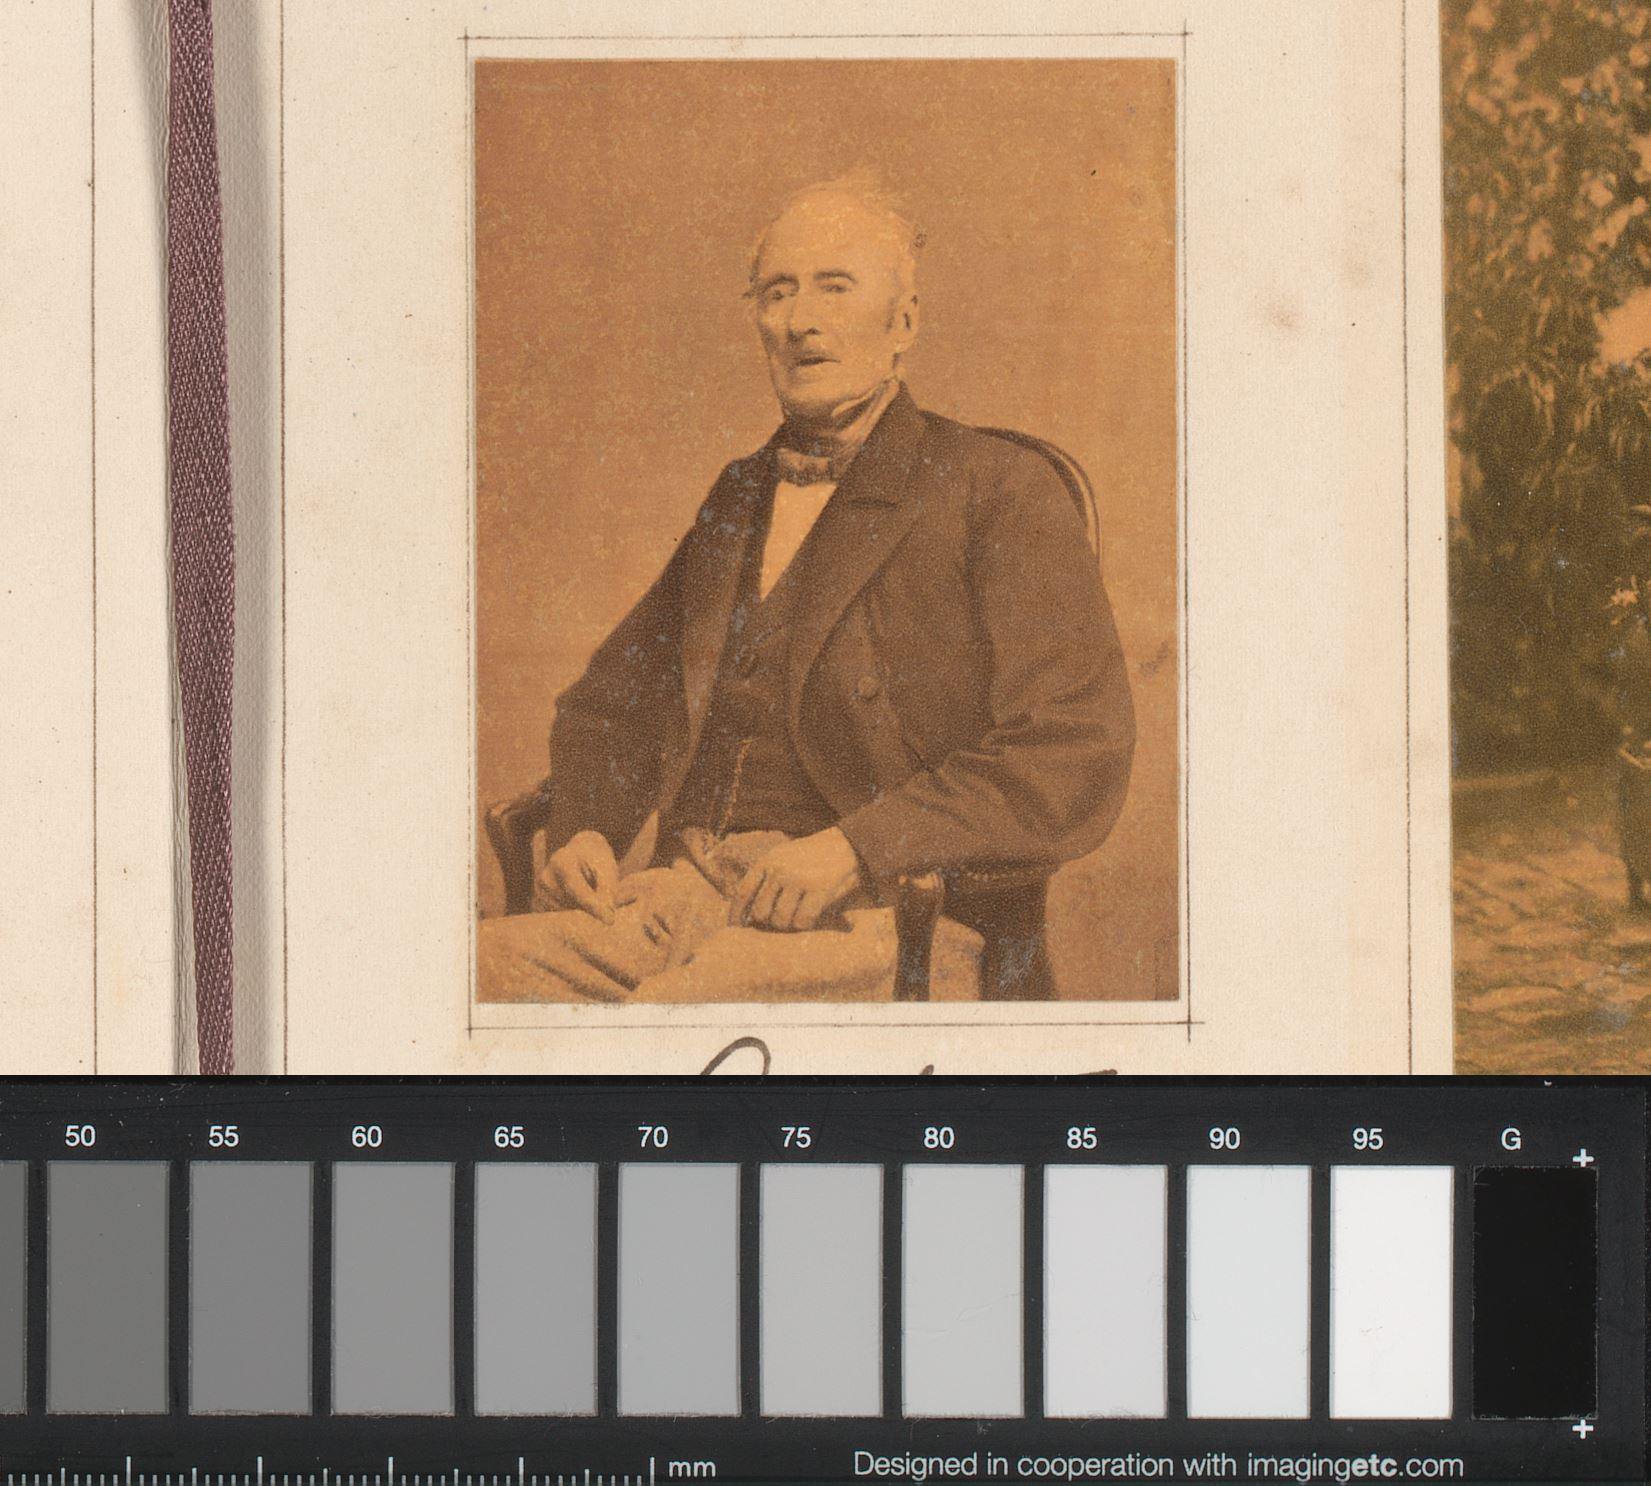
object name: album leaf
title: Portret van Alphonse de Lamartine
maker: Anonymous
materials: paper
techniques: rotogravure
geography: france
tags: paris, writer, poet, author, france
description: Deze prent maakt deel uit van een album.